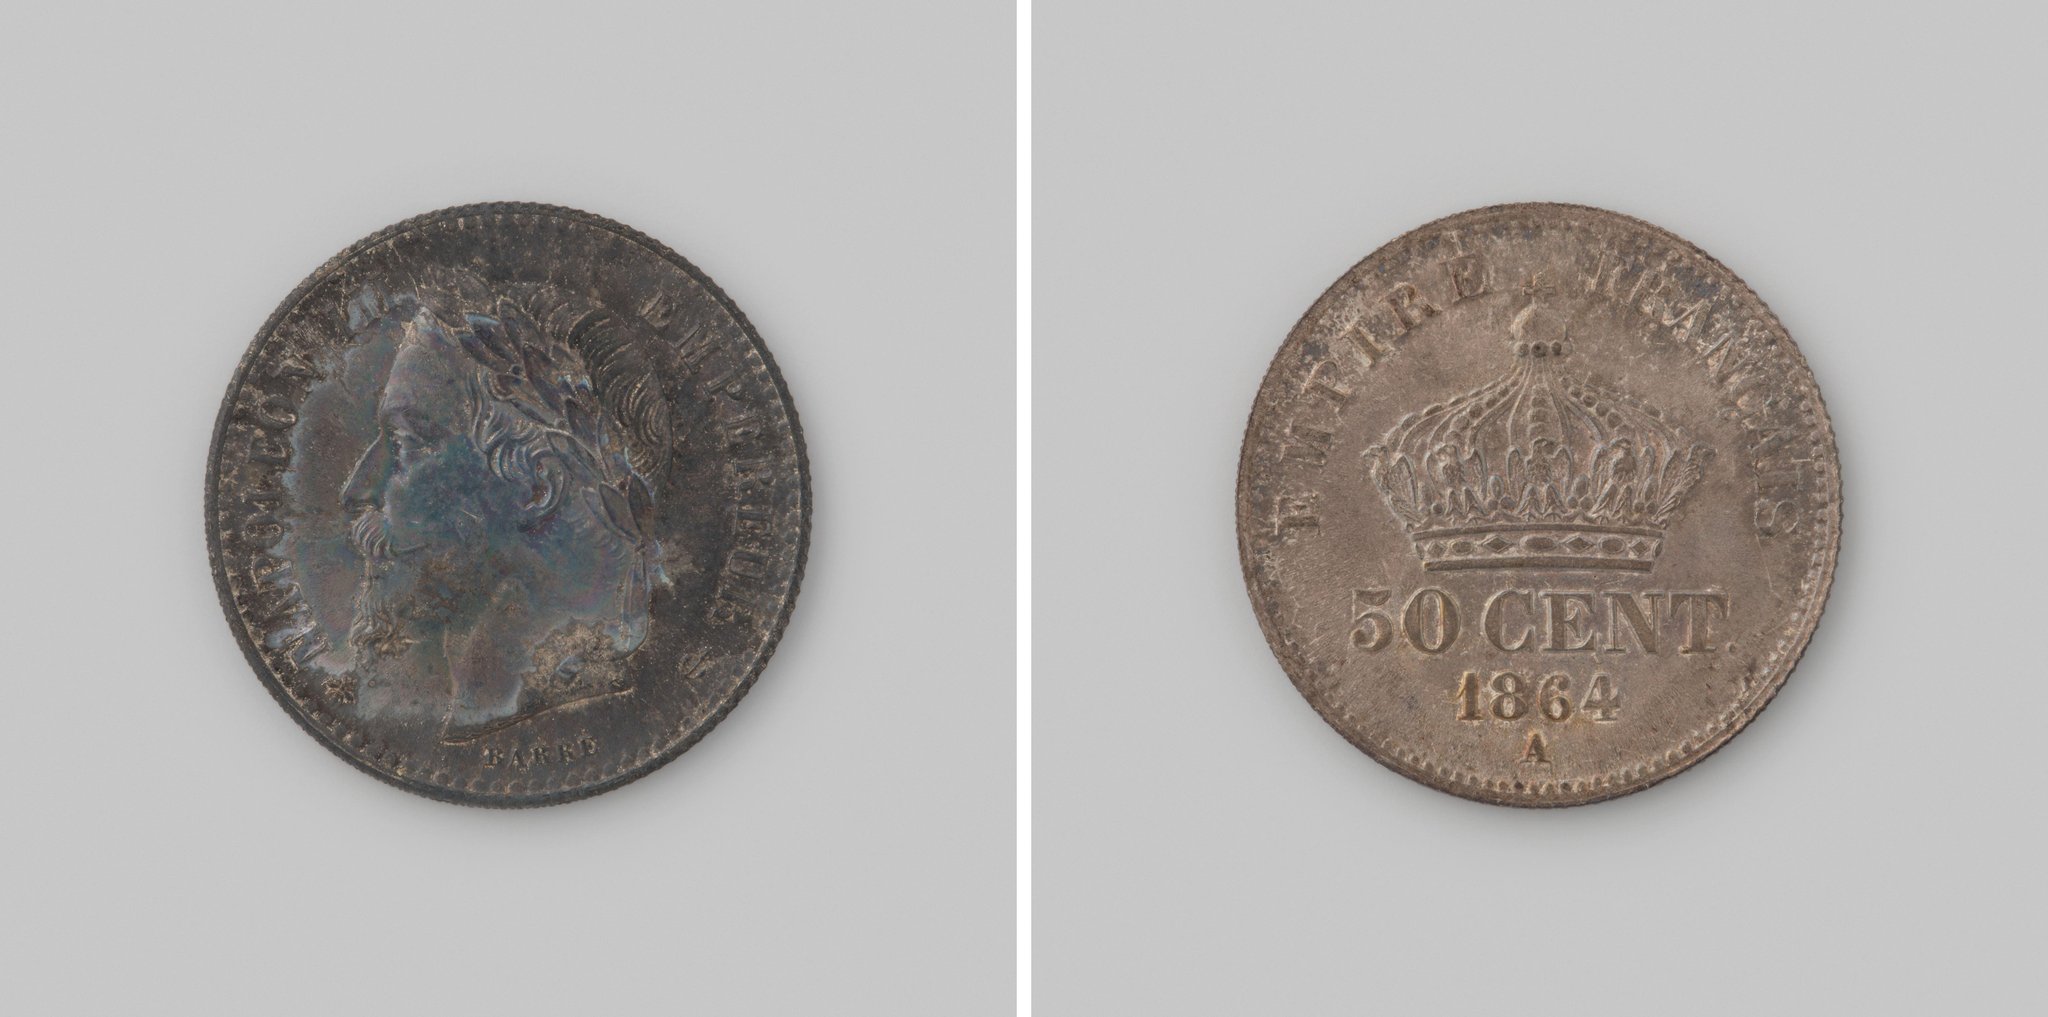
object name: vijftig centime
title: 50 centimes uit het keizerrijk Frankrijk van Napoleon III,1864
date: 1864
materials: silver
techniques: striking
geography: paris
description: Zilveren munt. Voorzijde: gelauwerd hoofd van de keizer naar links. Keerzijde: kroon, waaronder waarde-aanduiding in een regel, waaronder jaartal. Onderaan de letter A [=Parijs]. Kartelrand.